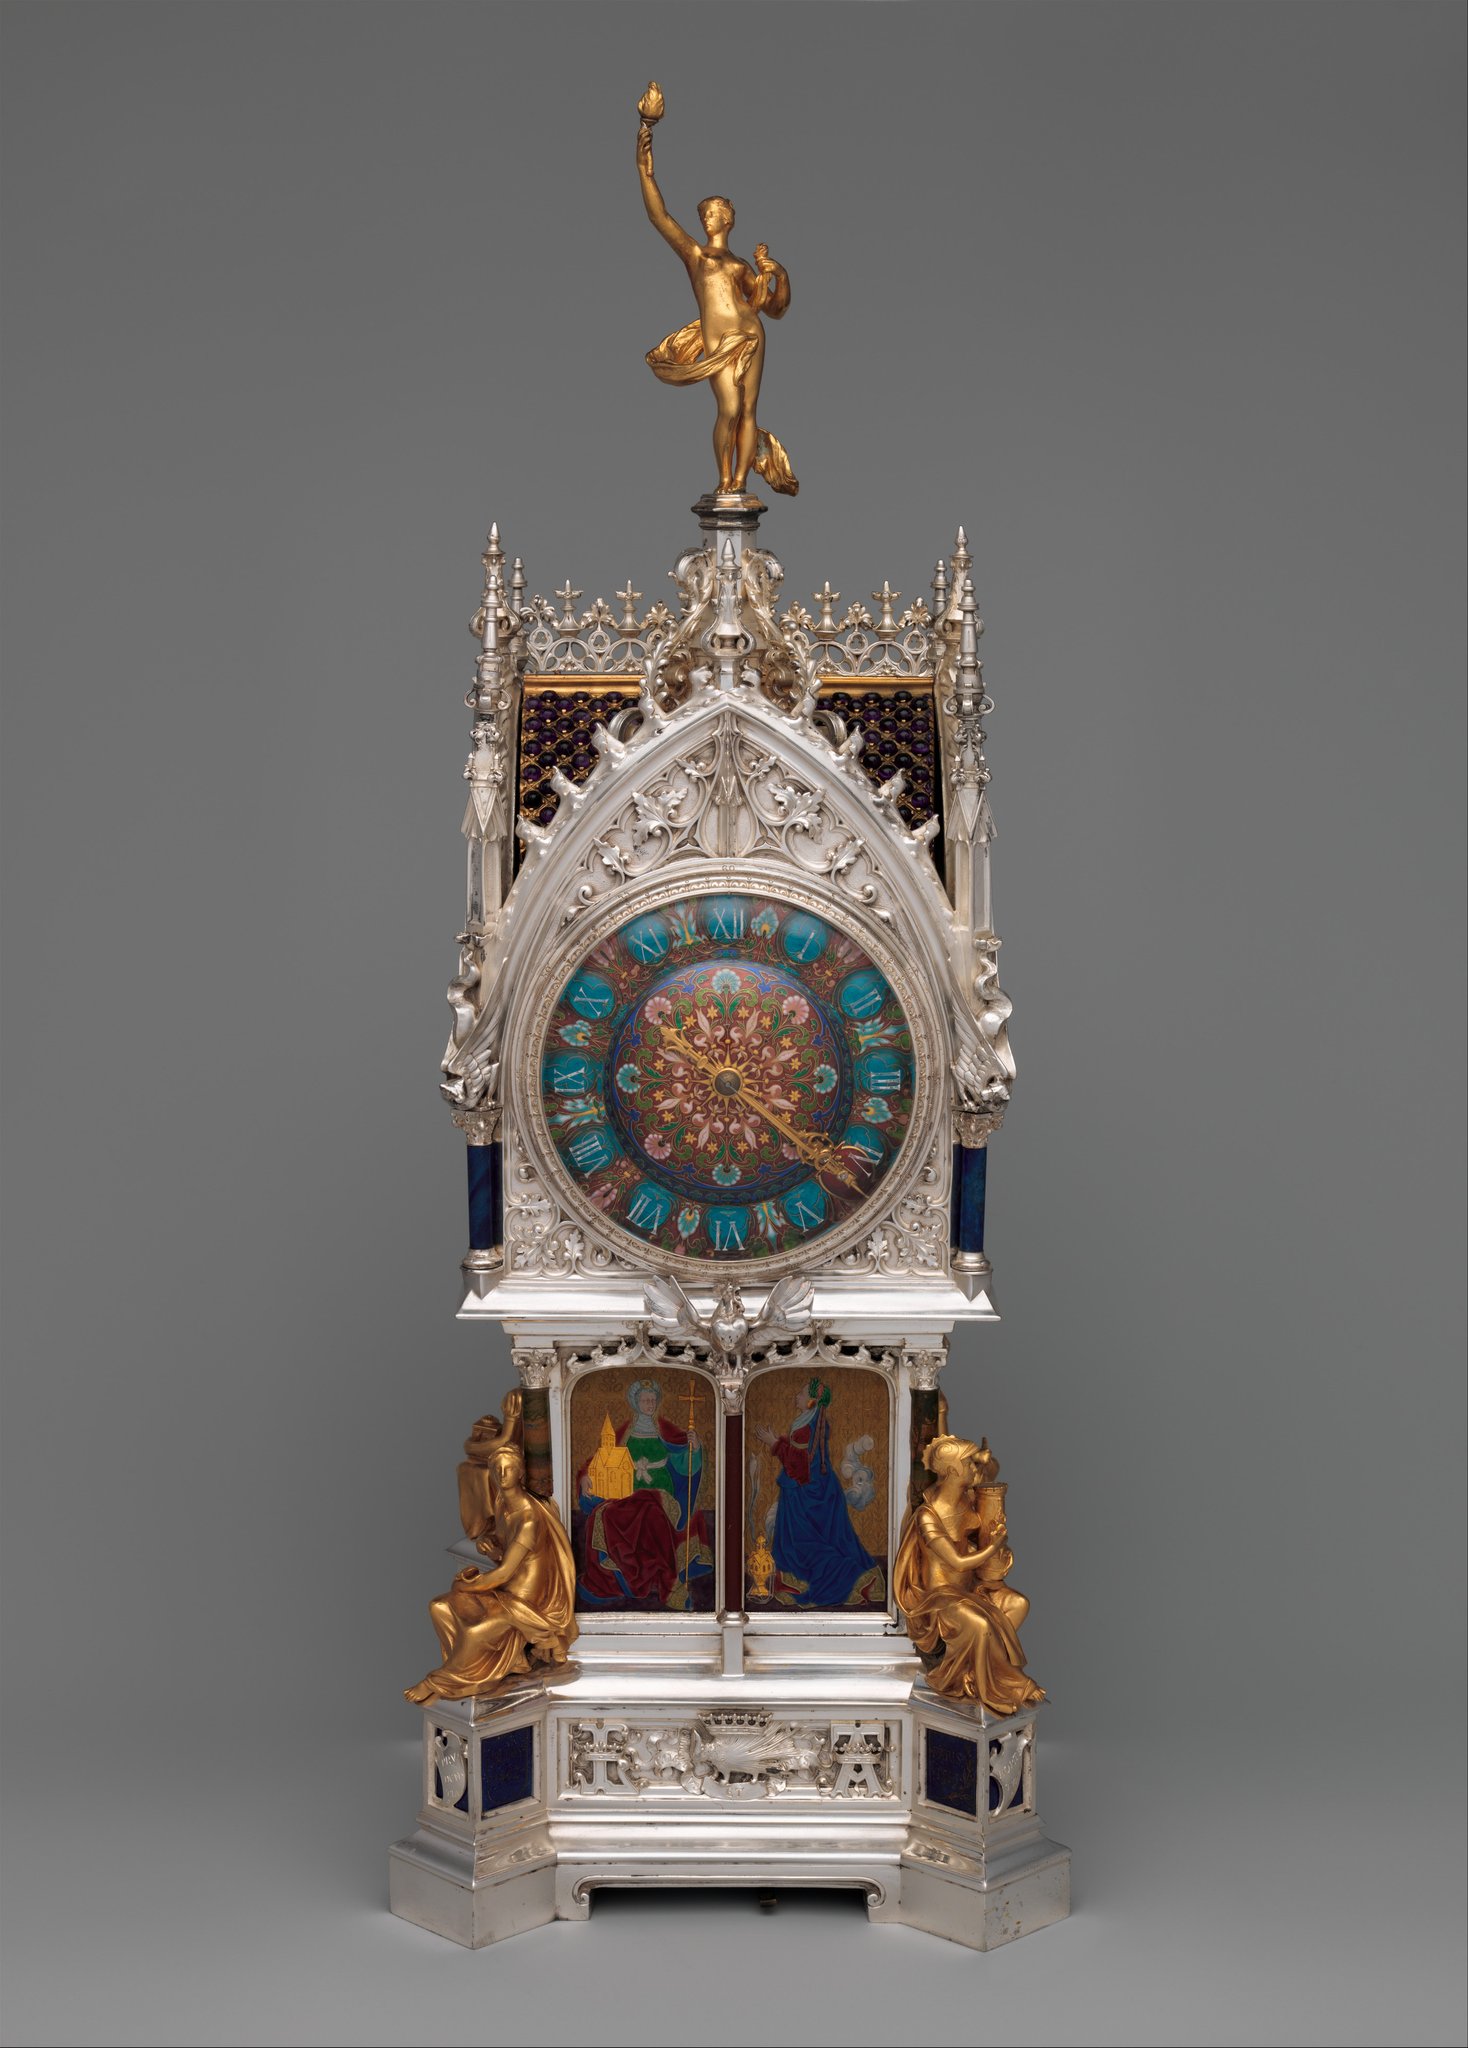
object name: clock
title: Table clock with calendar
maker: lucien falize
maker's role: designer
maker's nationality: french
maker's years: 1839-1897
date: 1881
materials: amethyst, brass, diamond, gold, quartz, silver, steel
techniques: enamel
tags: men,women